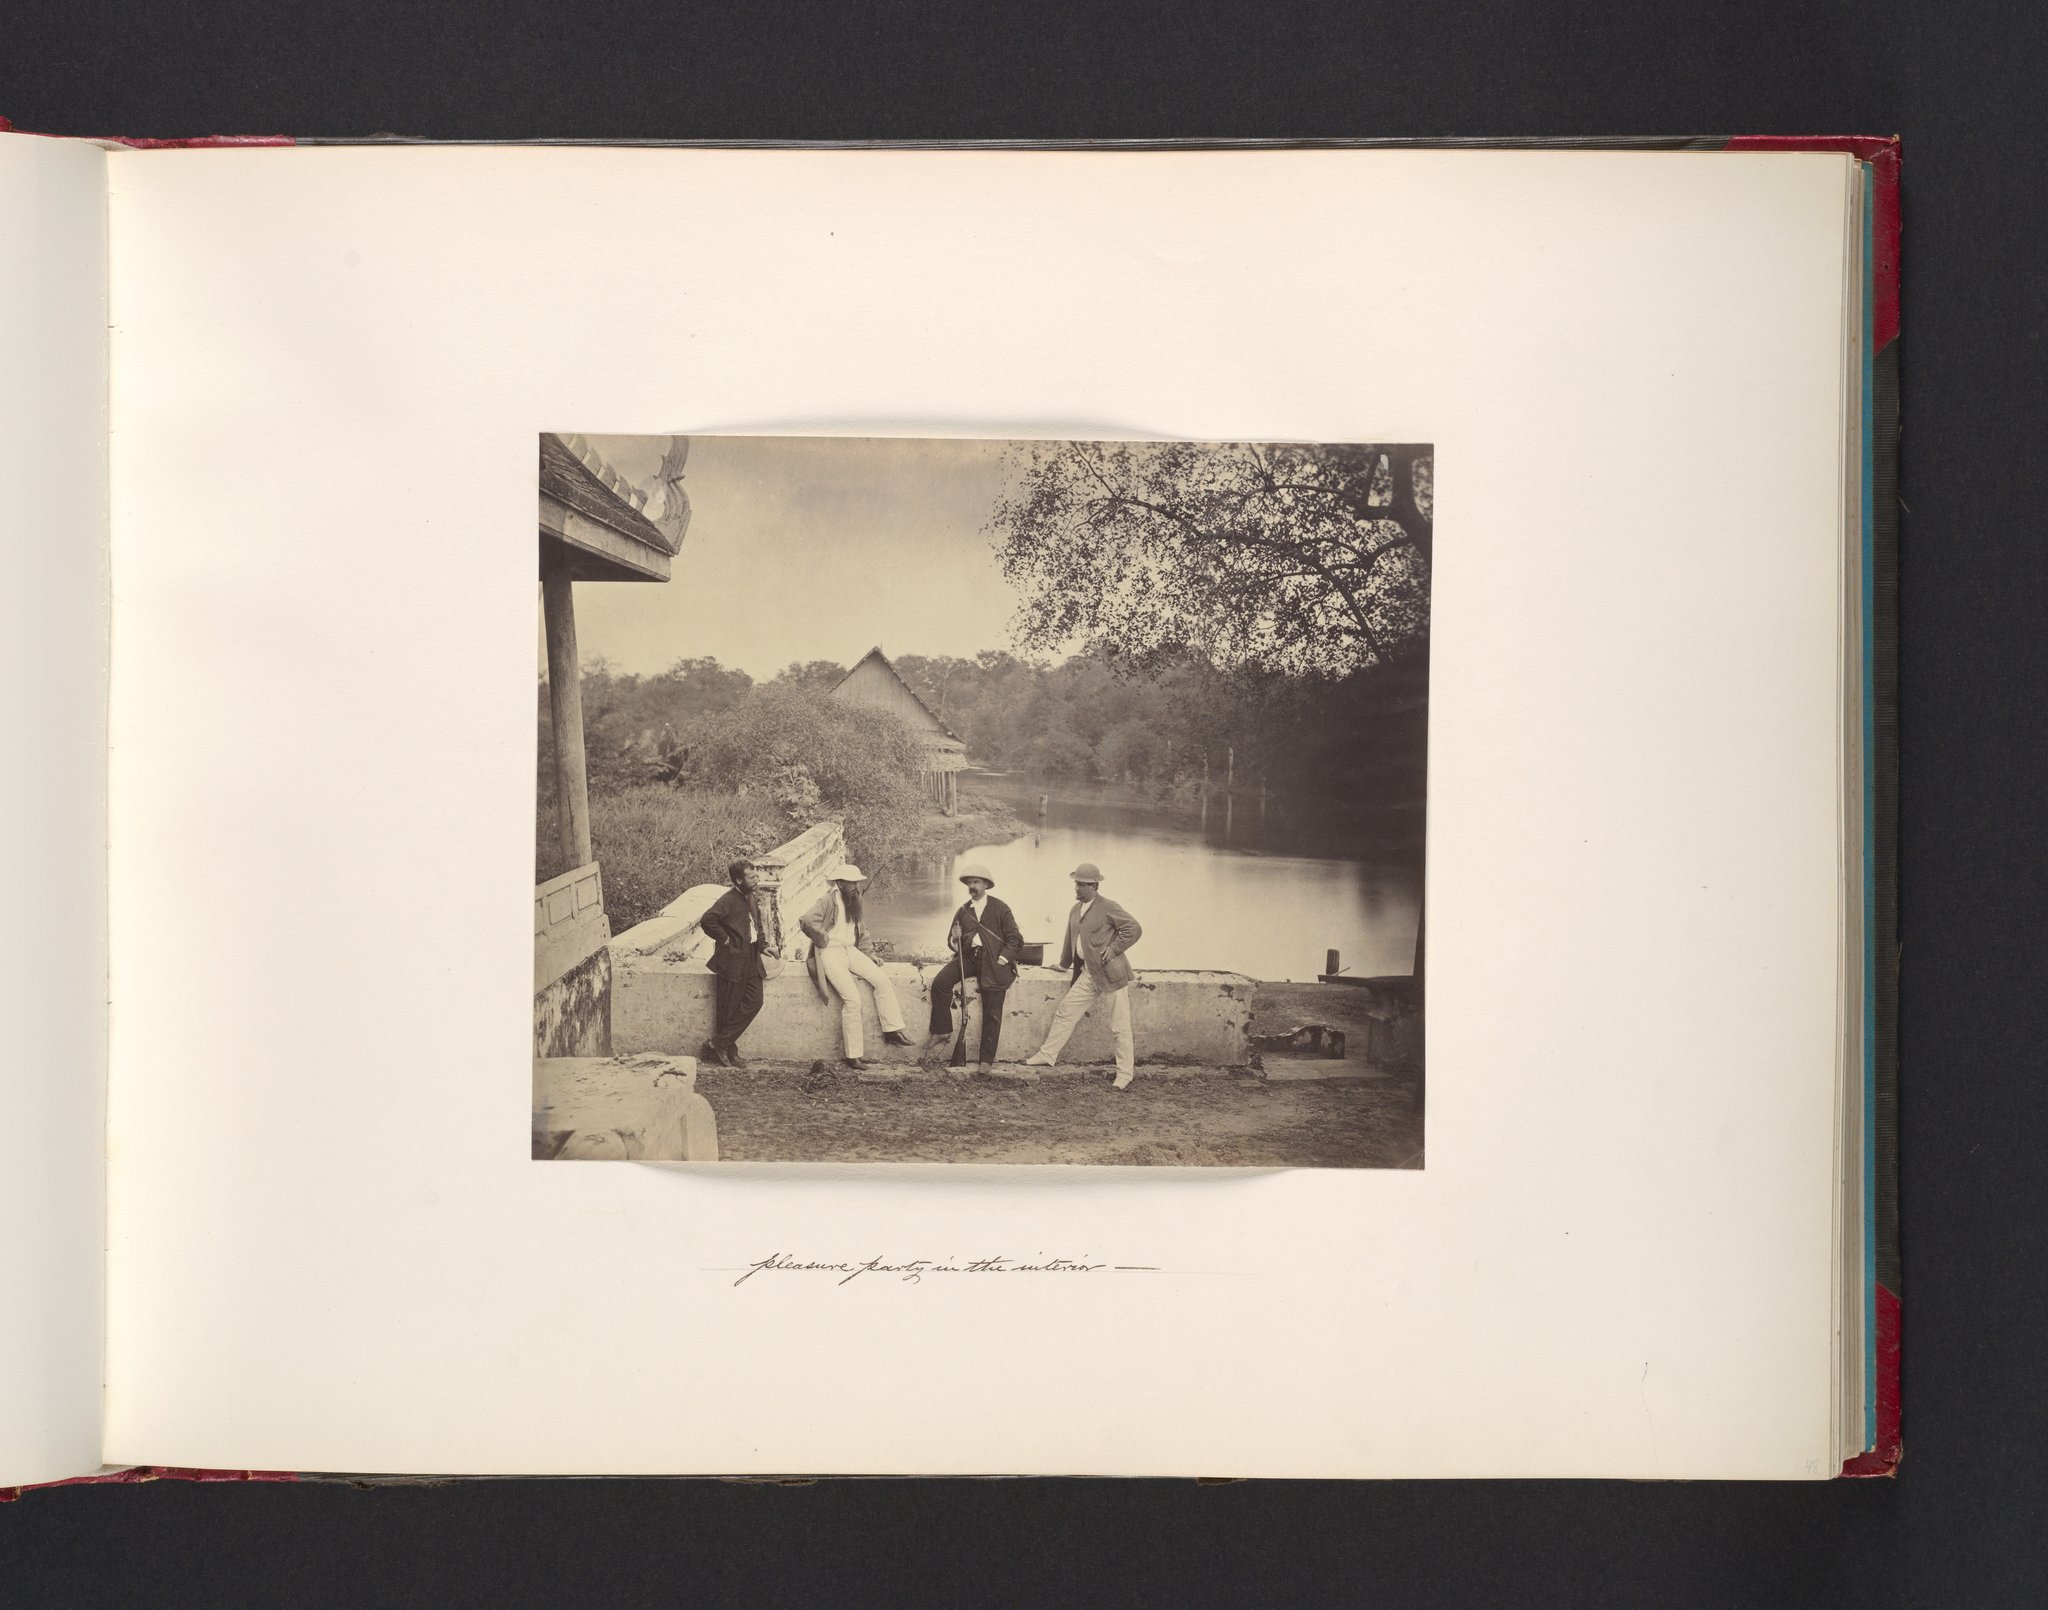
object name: photograph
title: Pleasure Party in the Interior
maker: john thomson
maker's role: artist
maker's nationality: british, scottish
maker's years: 1837-1921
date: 1865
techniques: albumen silver print, glass negative